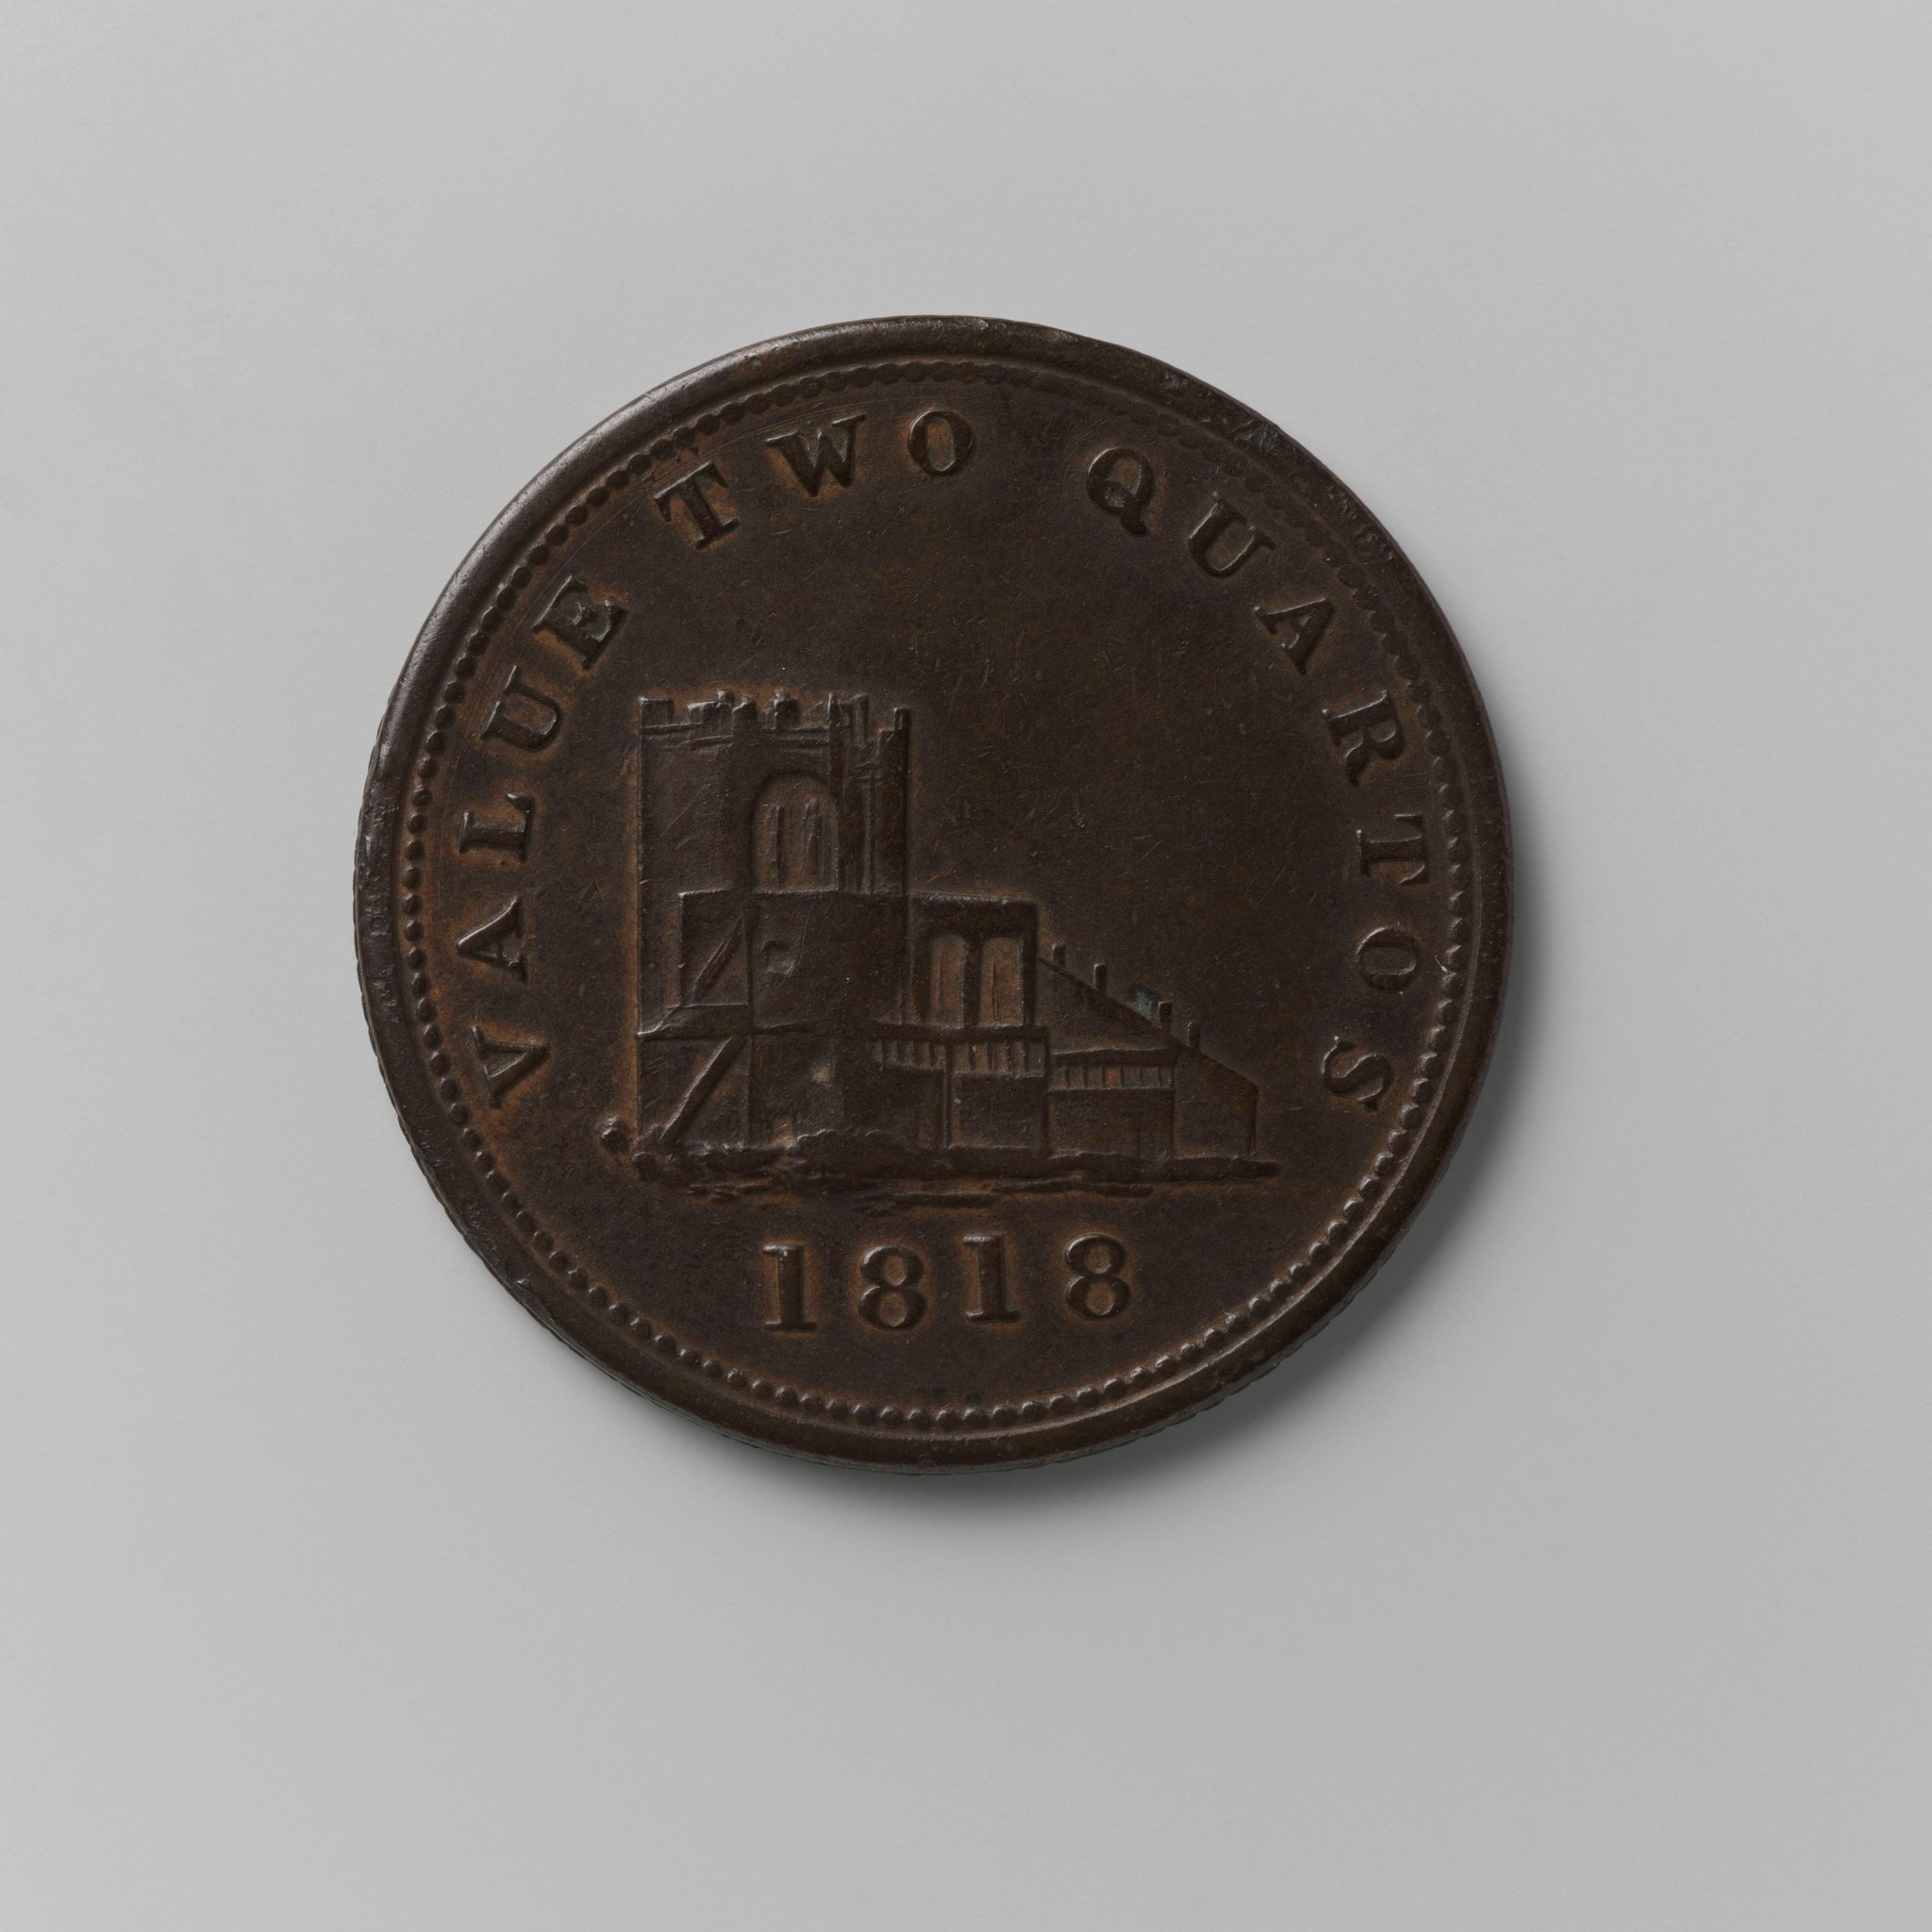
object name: coin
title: Gibraltar, 2 quartos, 1818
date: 1818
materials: copper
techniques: striking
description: Koperen particuliere munt. Voorzijde: zittende leeuw naar links, in rechterklauw sleutel. Keerzijde: kasteel, waaronder jaartal. waarde-aanduiding in omschrift. Kabelrand.